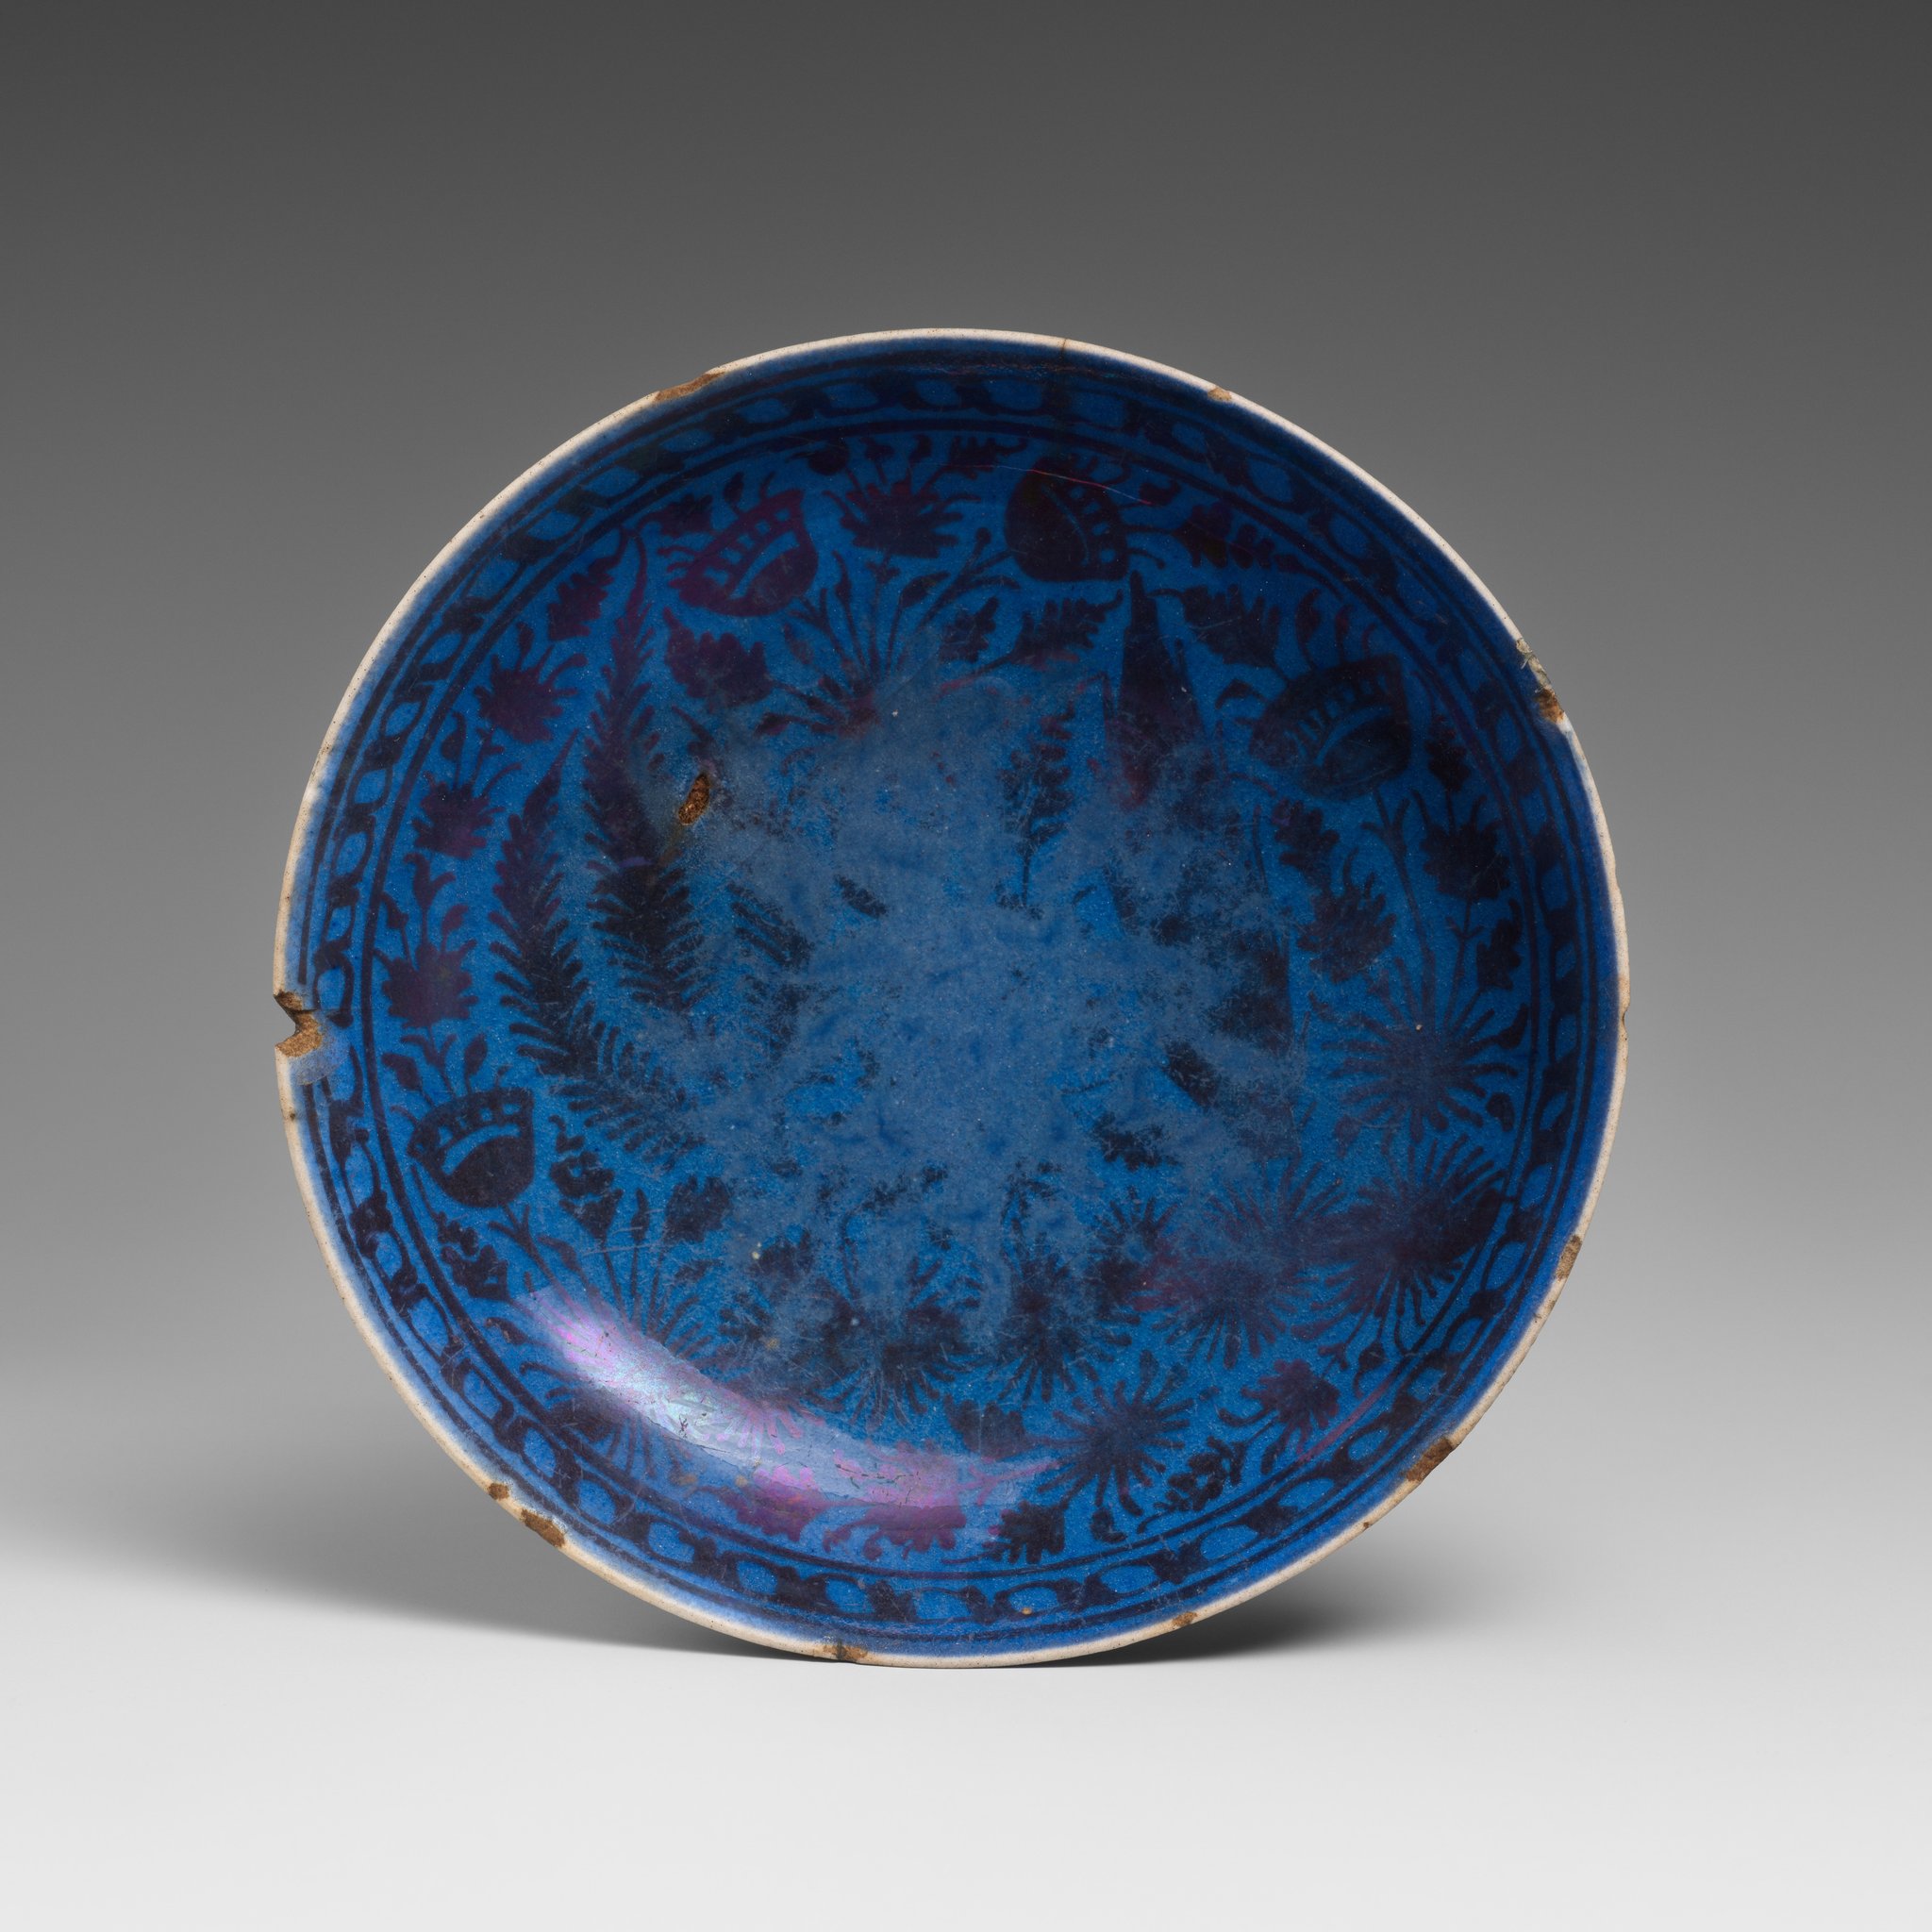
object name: dish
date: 1601-1700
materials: glaze, stonepaste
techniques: luster painting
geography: iran